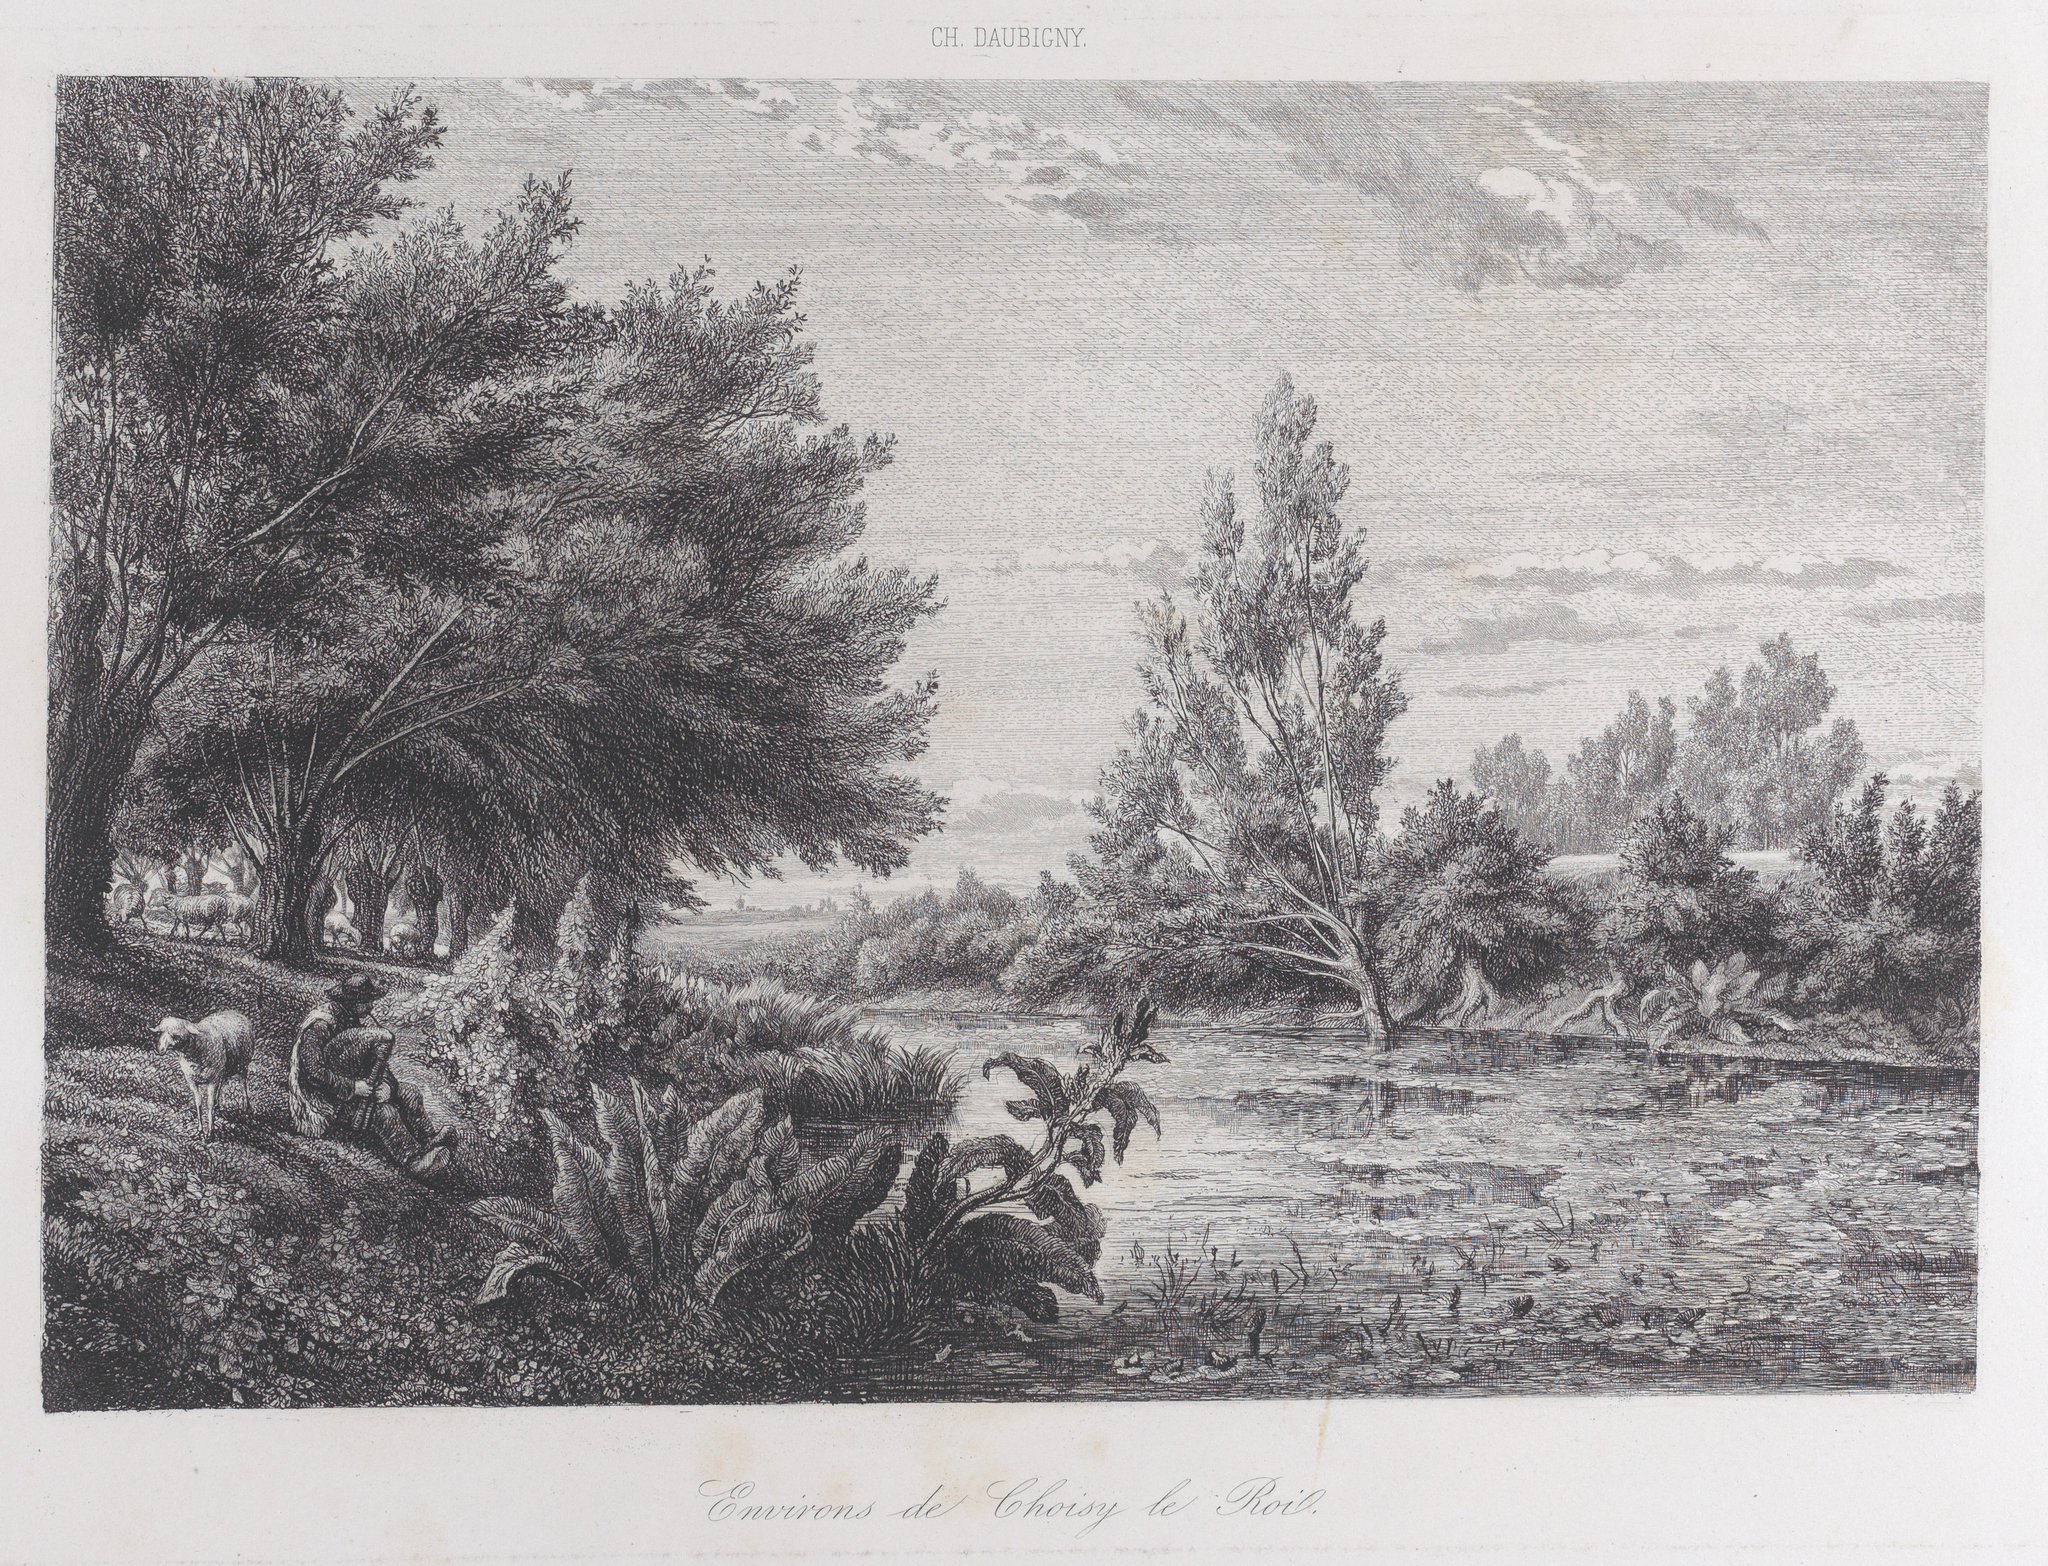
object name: print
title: Environs de Choisy-le-Roi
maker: charles-françois daubigny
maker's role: artist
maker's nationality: french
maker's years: 1817-1878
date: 1843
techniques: etching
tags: landscapes